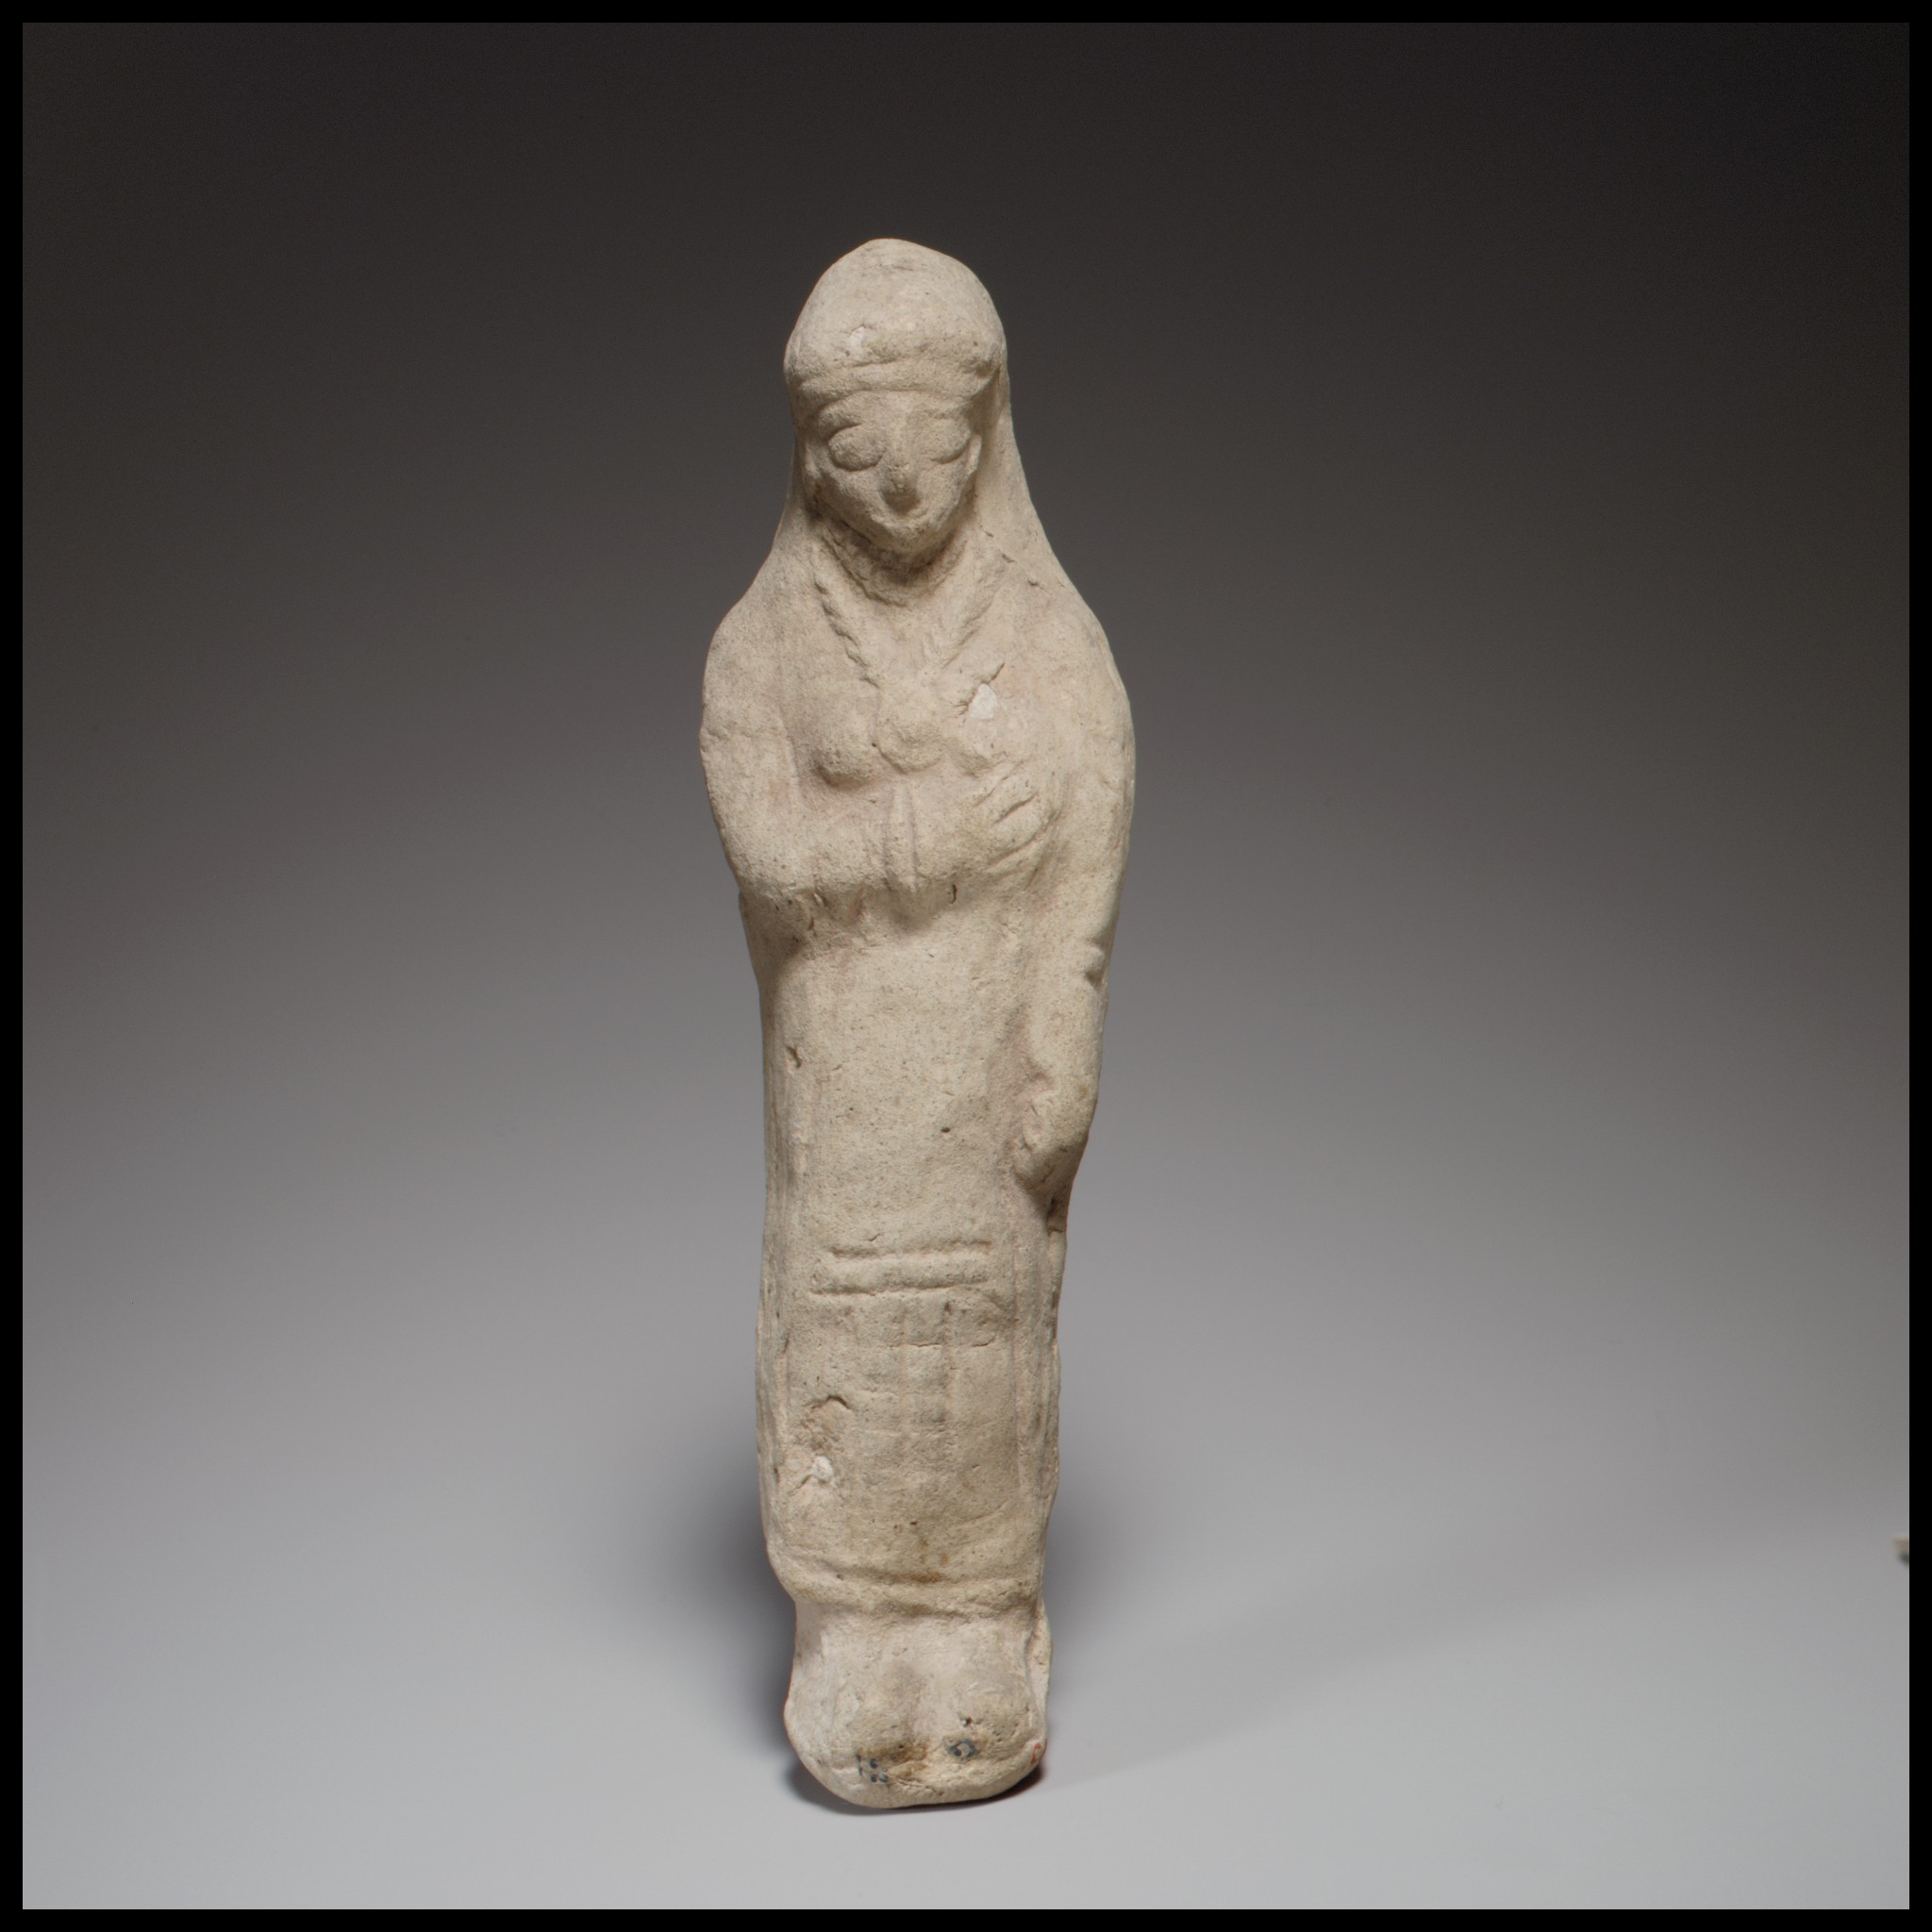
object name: statuette of a woman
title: Standing female figurine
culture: cypriot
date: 600-480 BCE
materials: terracotta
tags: women